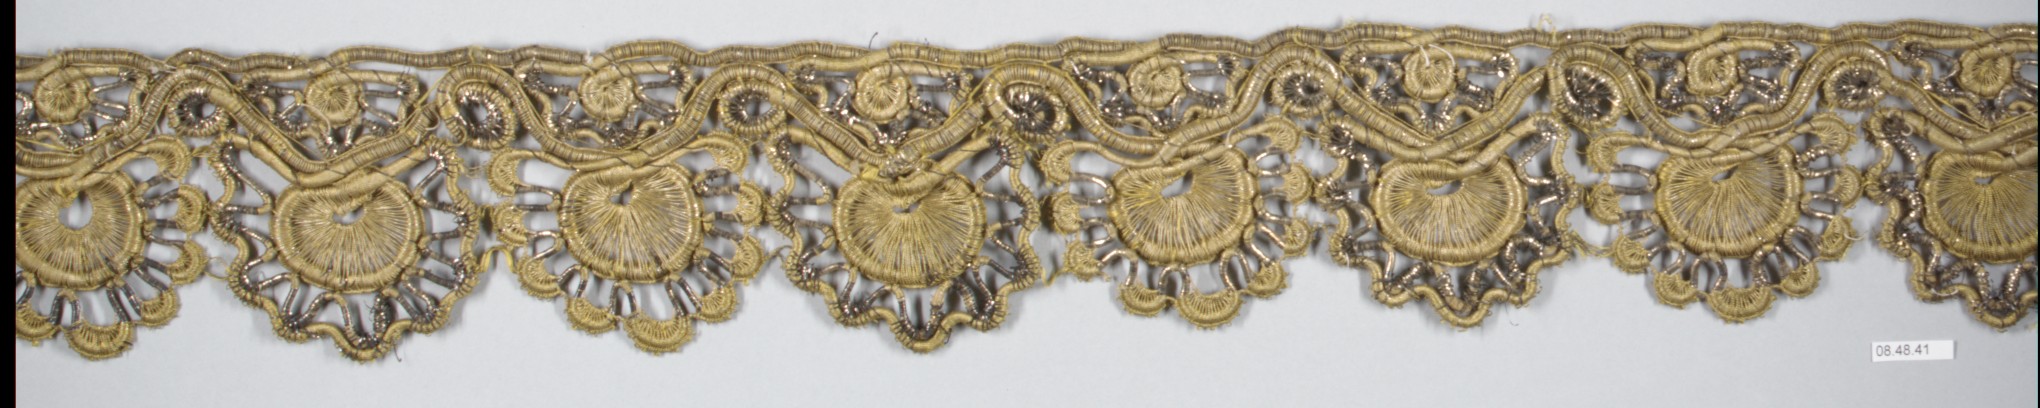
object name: passementerie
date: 1701-1900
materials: silk